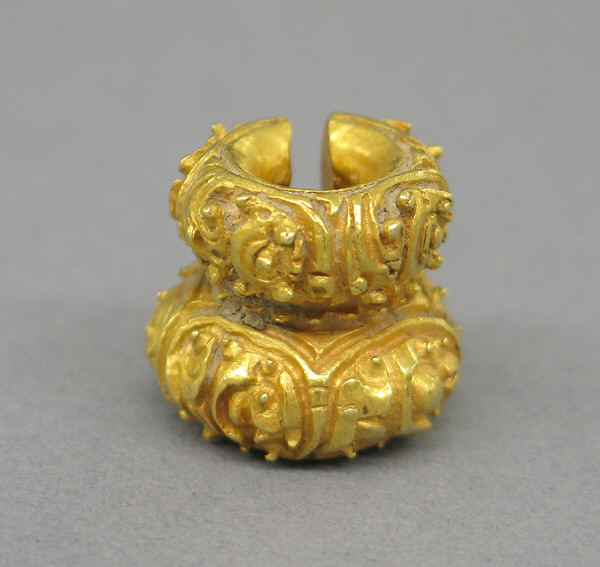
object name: fastener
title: Weighted Fastener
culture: indonesian, javanese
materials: gold